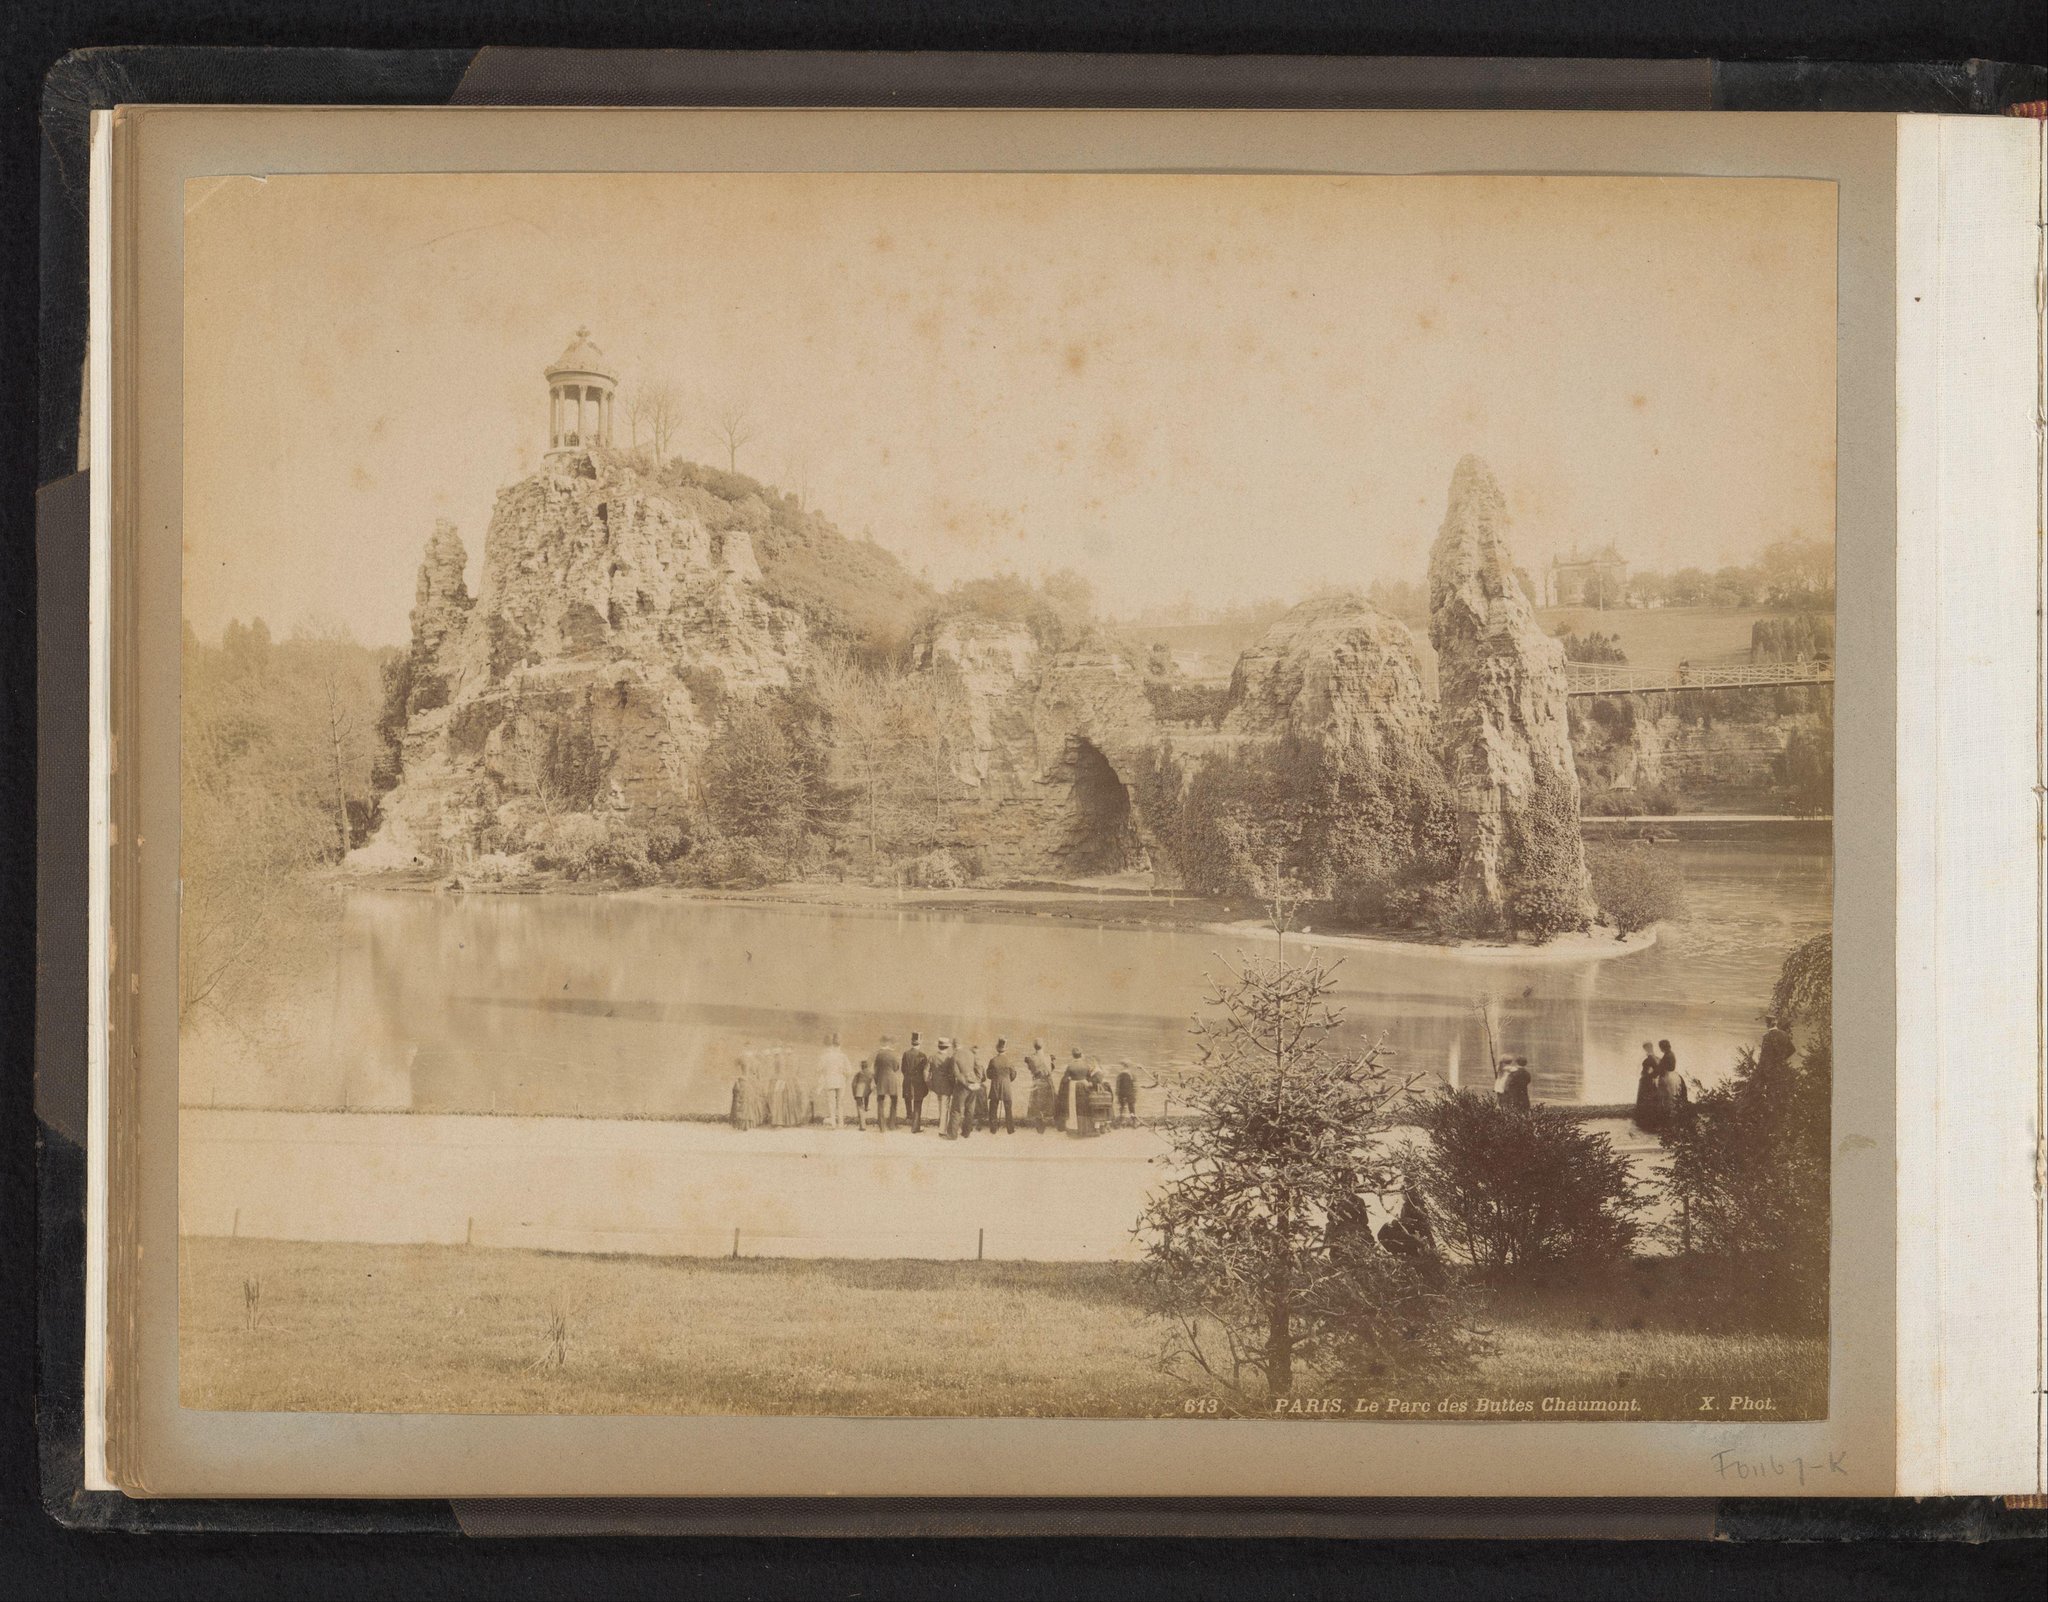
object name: photograph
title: Toeschouwers bij Parc des Buttes-Chaumont te Parijs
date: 1887-1910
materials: photographic support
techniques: albumen print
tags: historical persons, public gardens, park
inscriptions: inscription: ‘613 Paris _ Le Parc des Buttes-Chaumont’